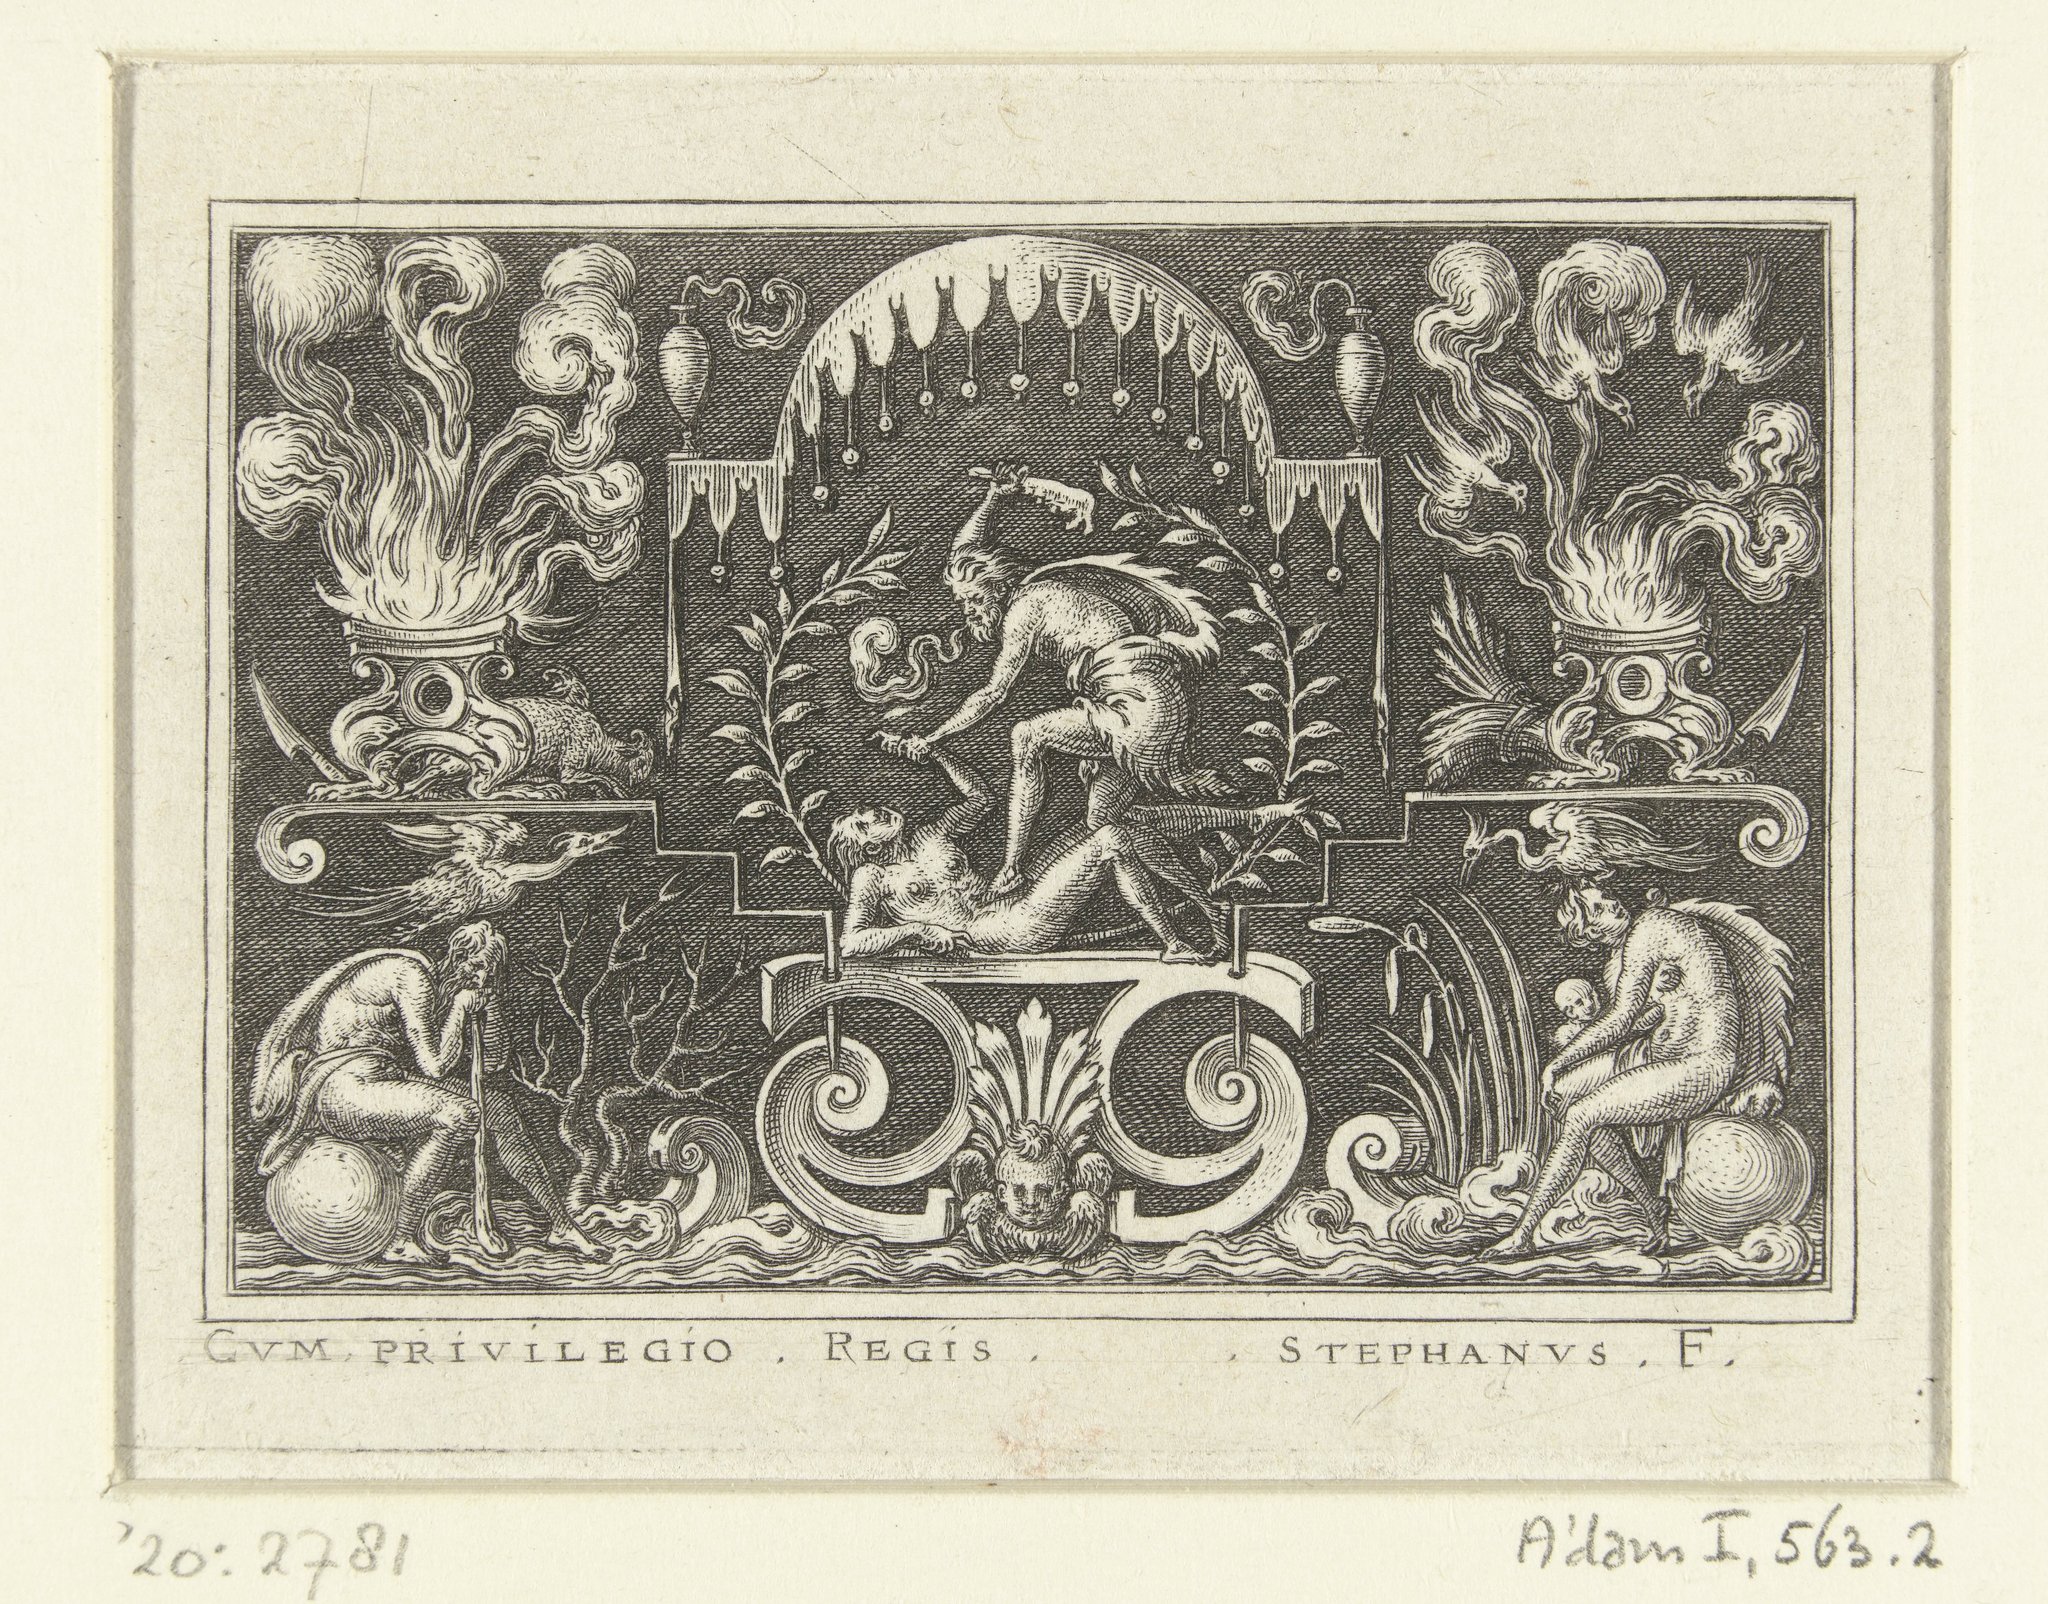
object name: ornament print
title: Kaïn doodt Abel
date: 1528-1583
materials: paper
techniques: engraving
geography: france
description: Rechtsonder zit een vrouw met een kind bij het riet. Uit serie van 6 bladen.